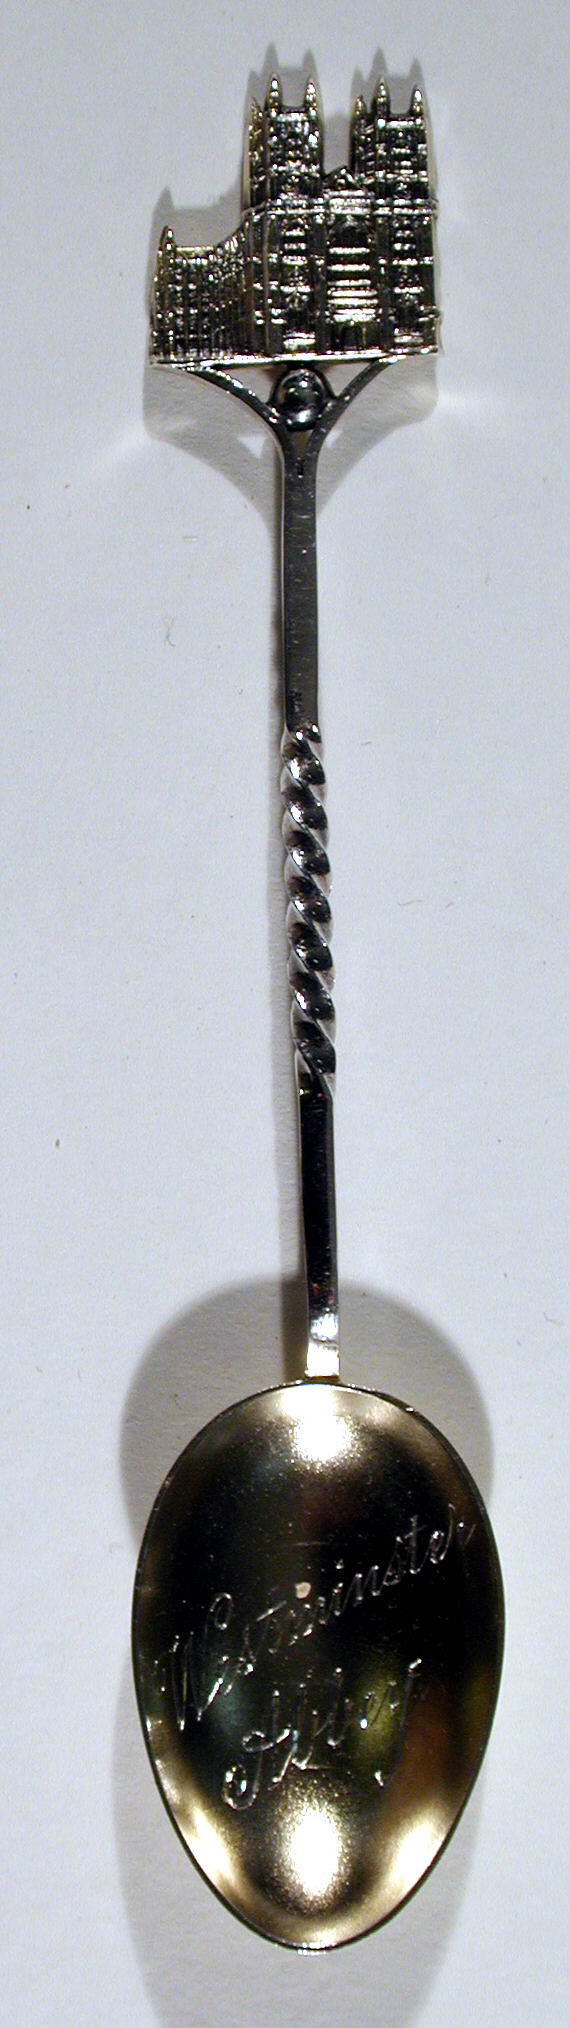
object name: souvenir spoon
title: Souvenir spoon with finial in form of west front of Westminster Abbey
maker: saunders & shepherd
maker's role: maker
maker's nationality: british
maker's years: 1869-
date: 1896-1897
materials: gilt, silver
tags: museums